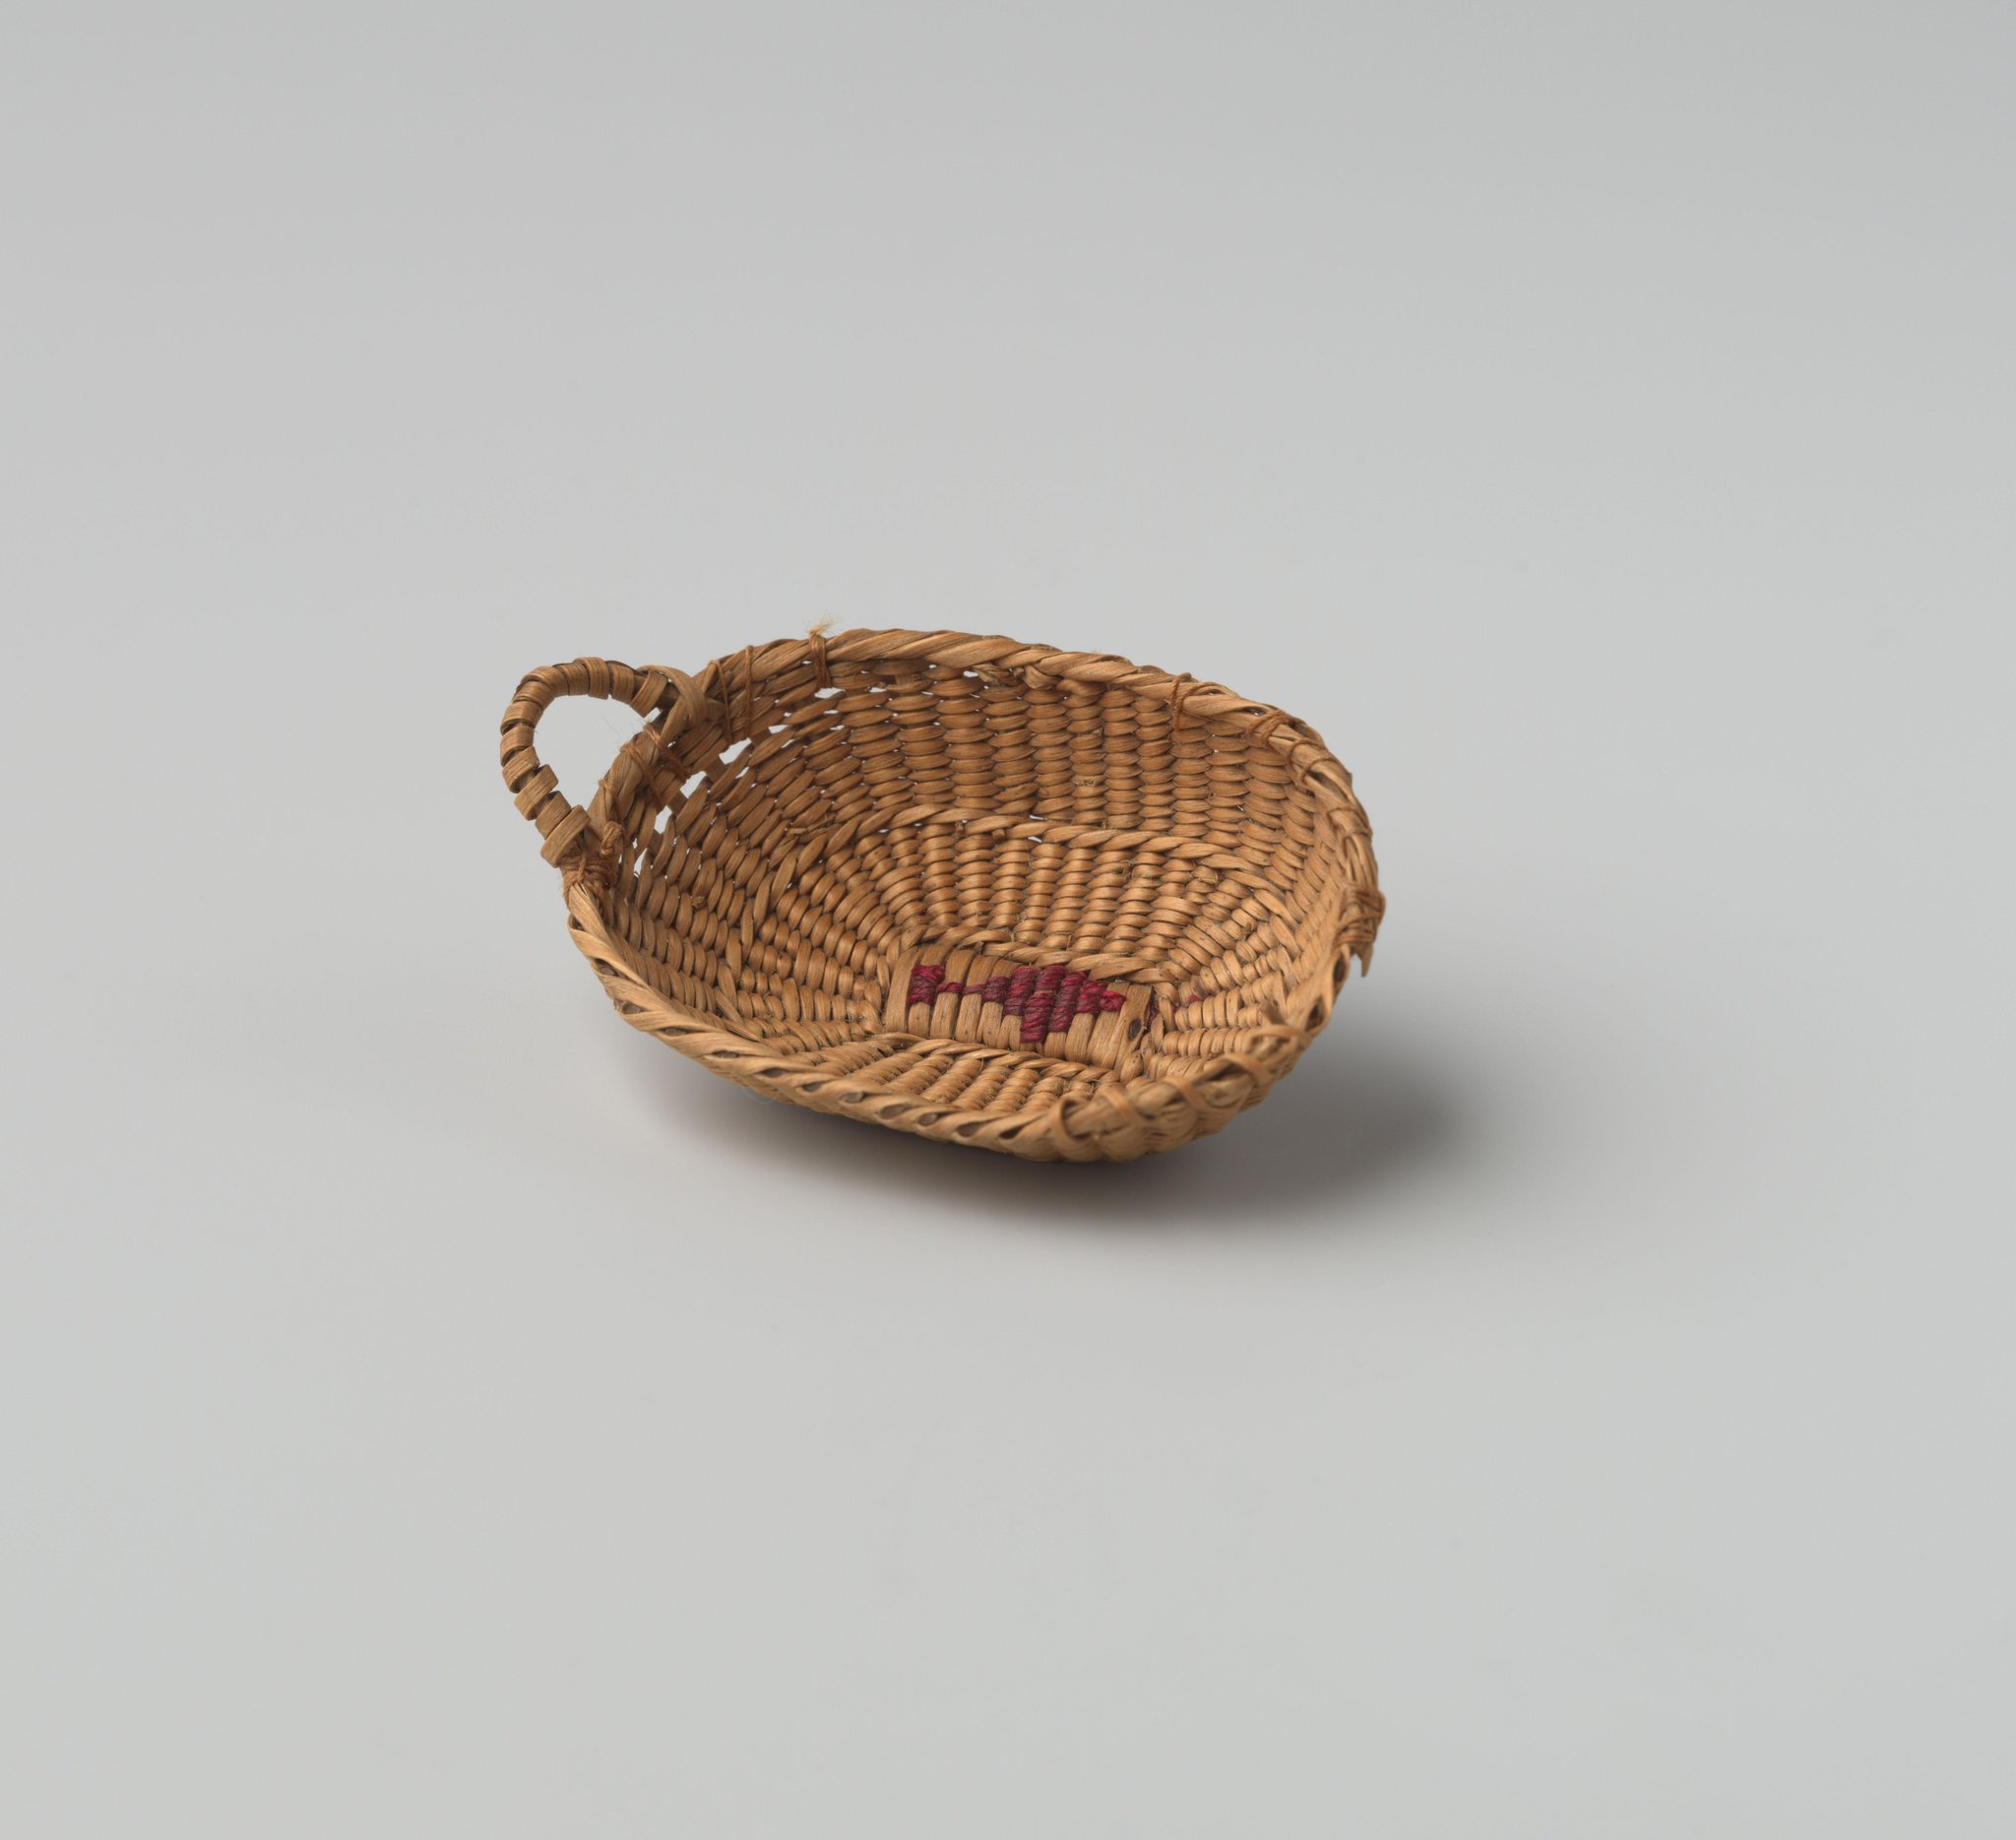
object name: miniature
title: Lage ovale mand van gespleten wilgenteen, fijnscheenwerk, met (oorspronkelijk twee) handvatten, verstevigd met donker paardehaar (?); bodem geborduurd met bloemmotief.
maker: Anonymous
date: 1675-1710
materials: hair, plant material, silk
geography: halle